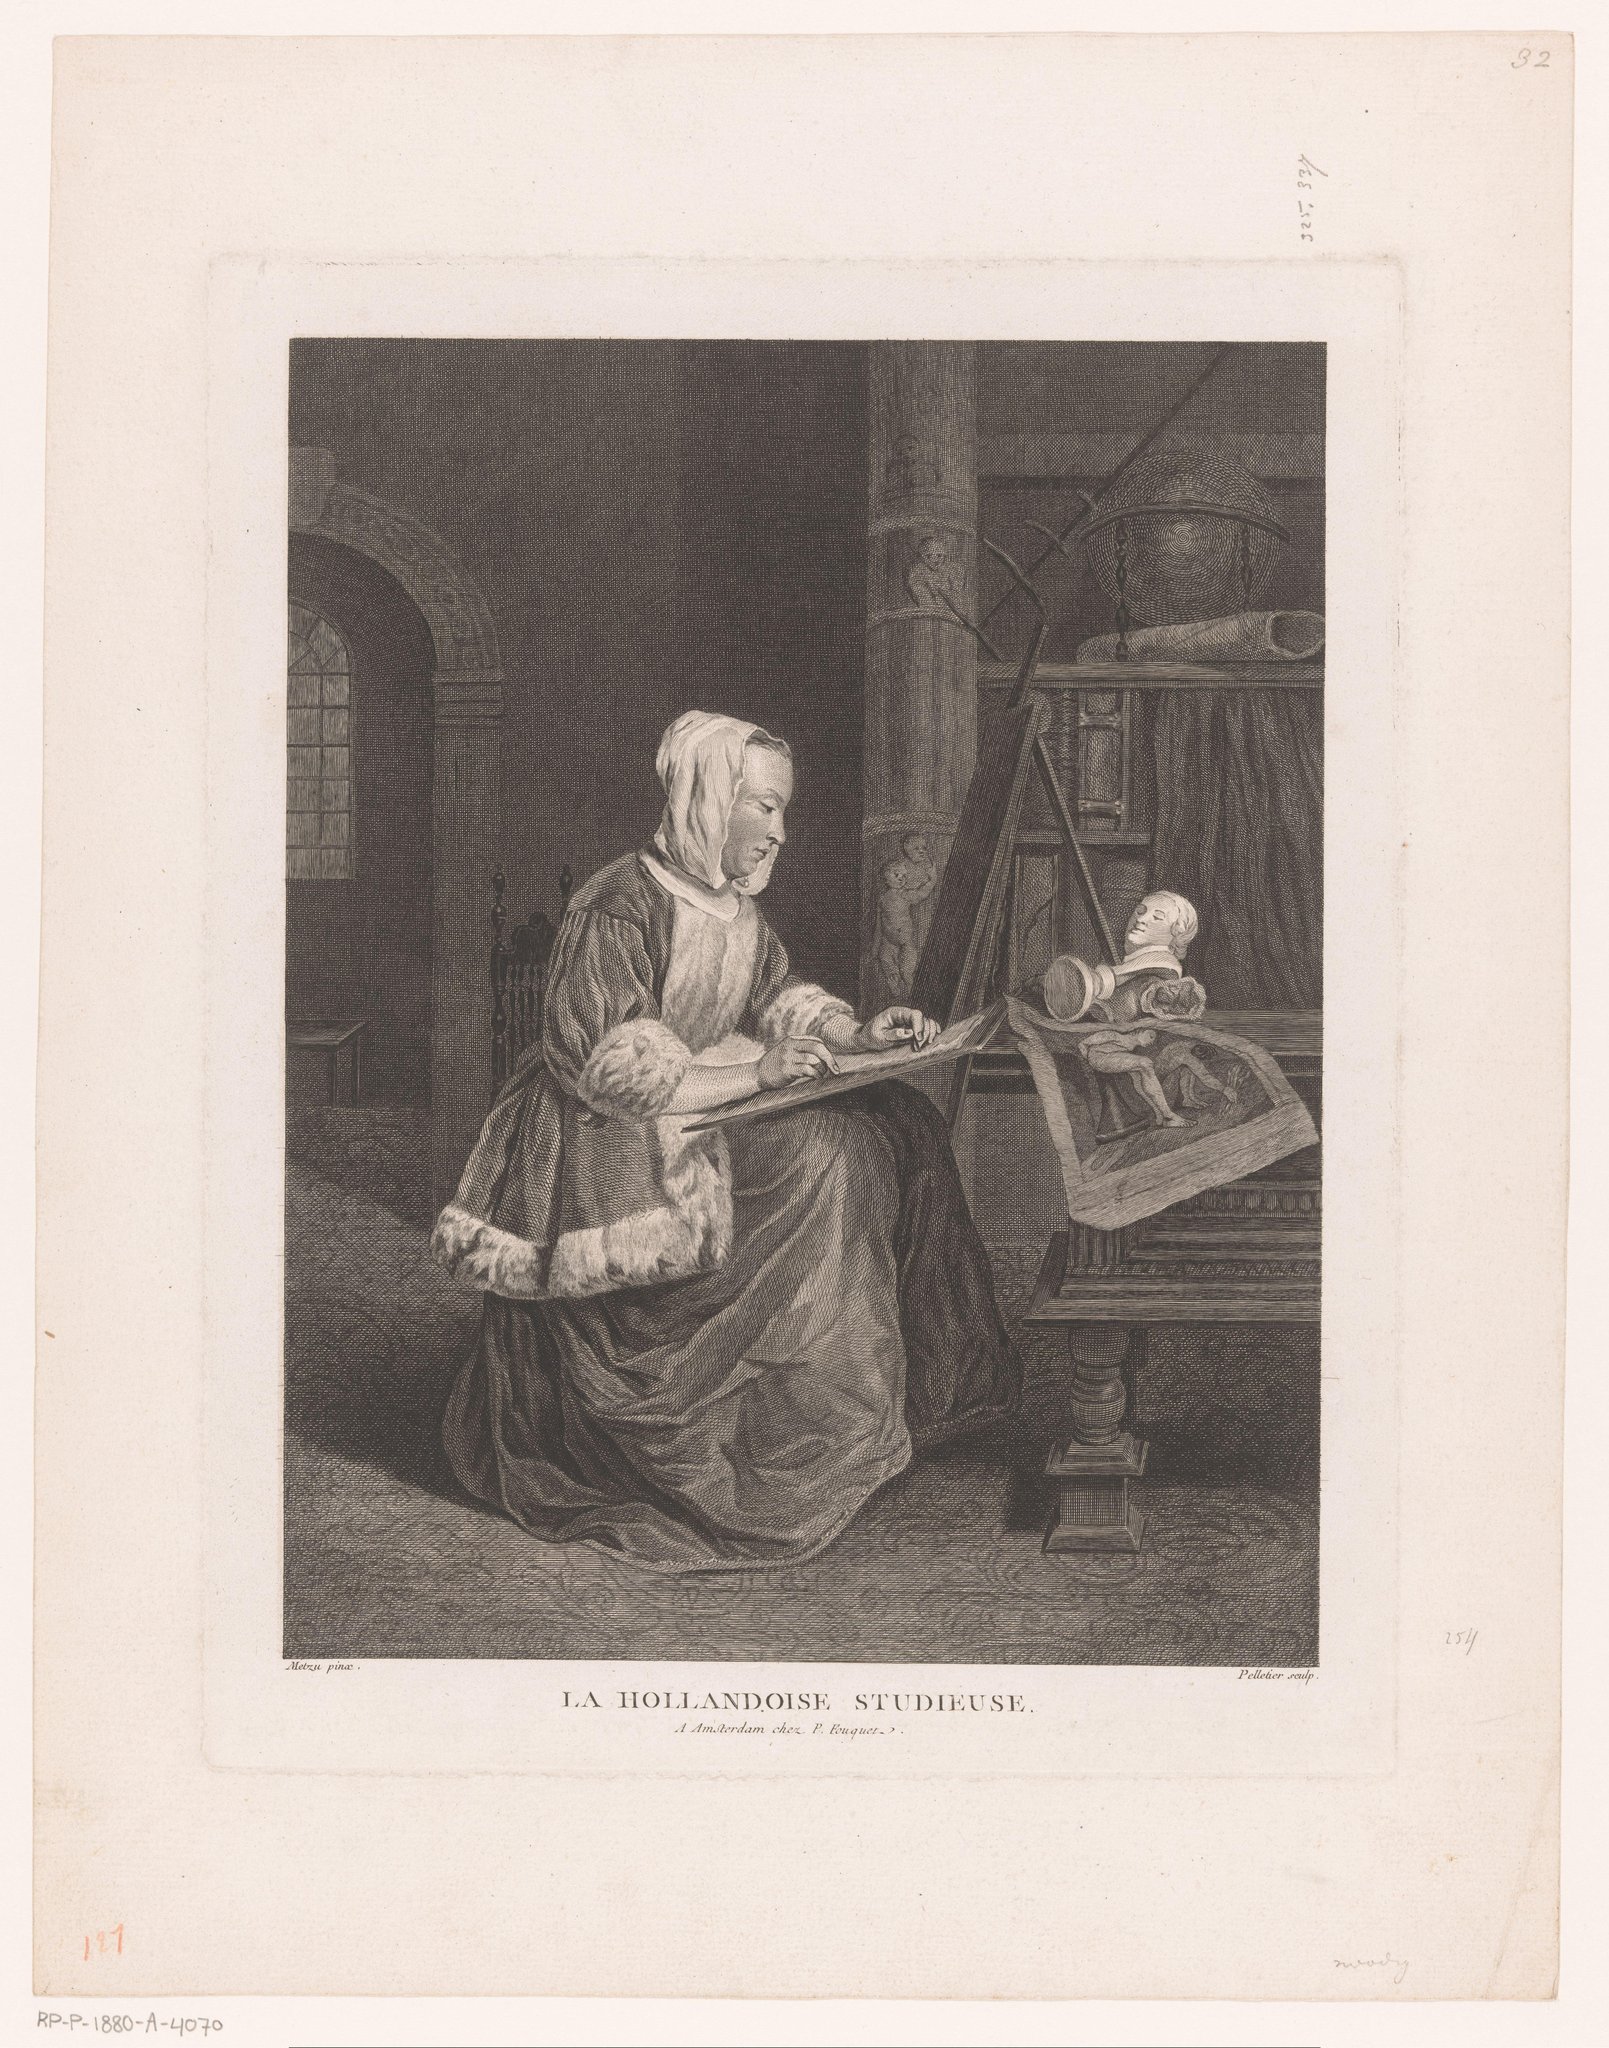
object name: print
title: Interieur met tekenende vrouw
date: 1746-1780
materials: paper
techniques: engraving, etching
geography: amsterdam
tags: draughtsman at work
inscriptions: collector's mark: Lugt 2228